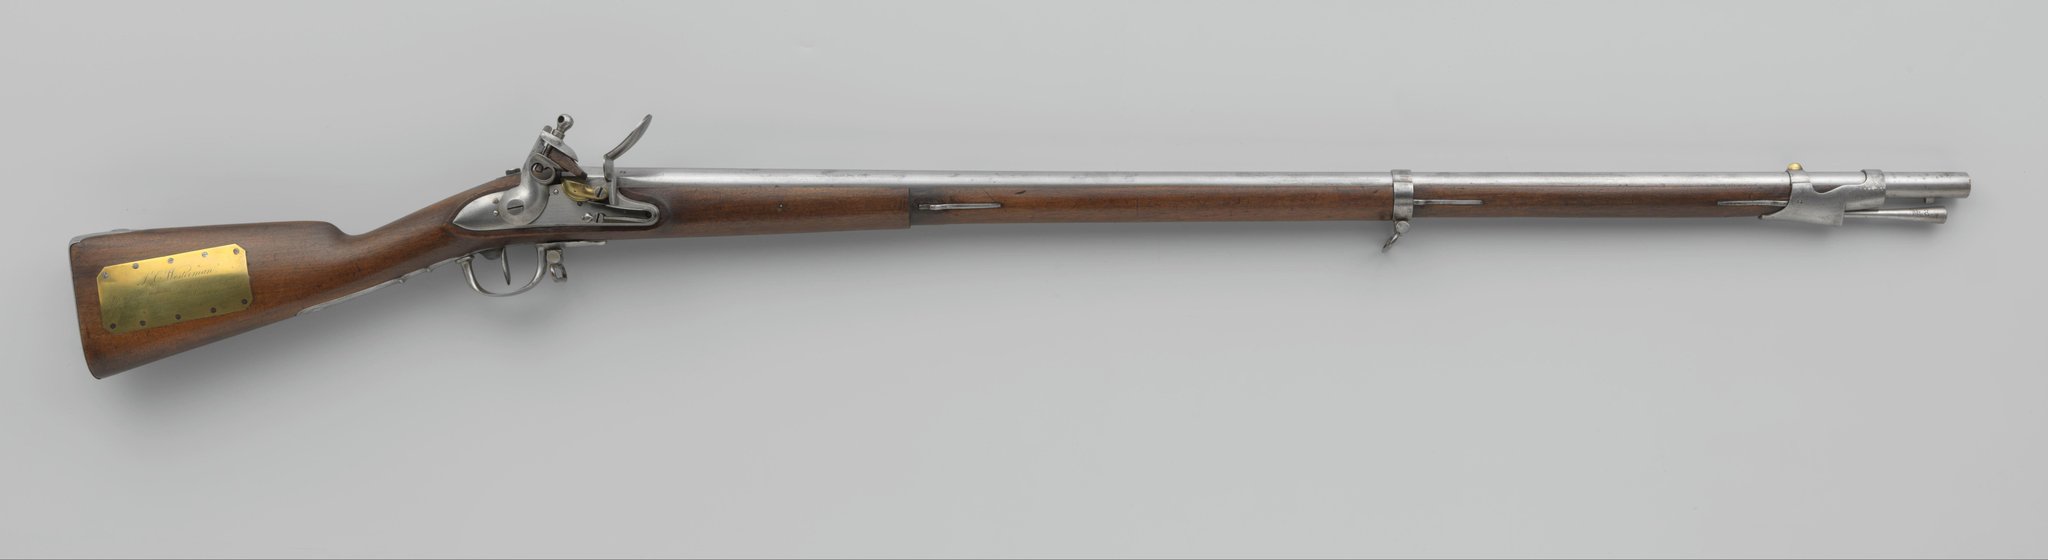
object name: flintlock pistol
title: Vuursteengeweer met bajonet van J.C. Westerman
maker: Anonymous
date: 1831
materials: copper, iron, wood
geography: netherlands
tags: louvain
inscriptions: inscription: ‘I.C. Westerman op den 12den augustus 1831 als Vrijwillig Jager bij het 2den batalion voor Leuven gesneuveld.’, : ‘23/11/09: Op het label in de map staat: M 1815 1828 1831 1012 IS 8’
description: Vuursteengeweer met ronde ijzeren loop. De lade en kolf zijn van hout. Ijzeren vuursteenslot. Op de kolf een plaquette van koper met inscriptie. Laadstok nr. 8 is van ijzer en bevindt zich in de laadstokkoker. Aan de lade en de trekkerbeugel zitten gespen voor de draagband bevestigd. De draagband ontbreekt. De pan in het vuursteenslot is van koper.